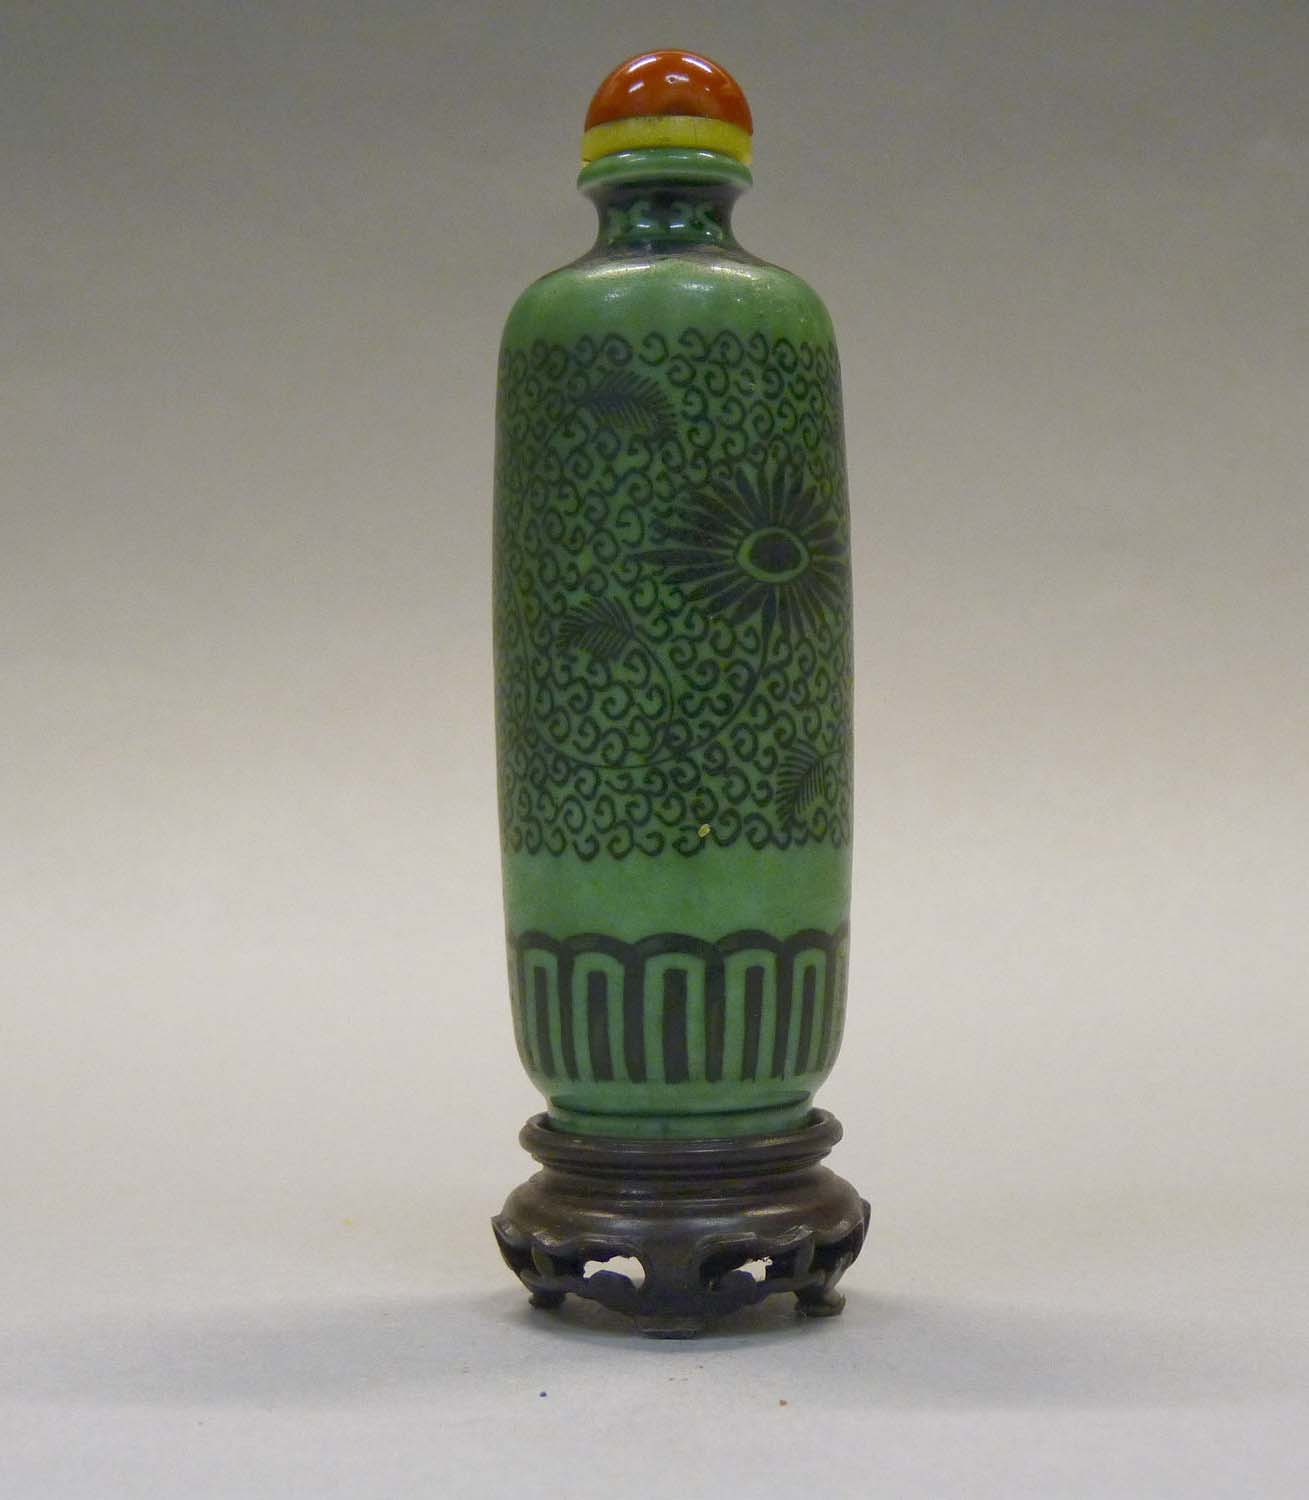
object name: snuff bottle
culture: chinese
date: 1801-1900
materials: coral, porcelain